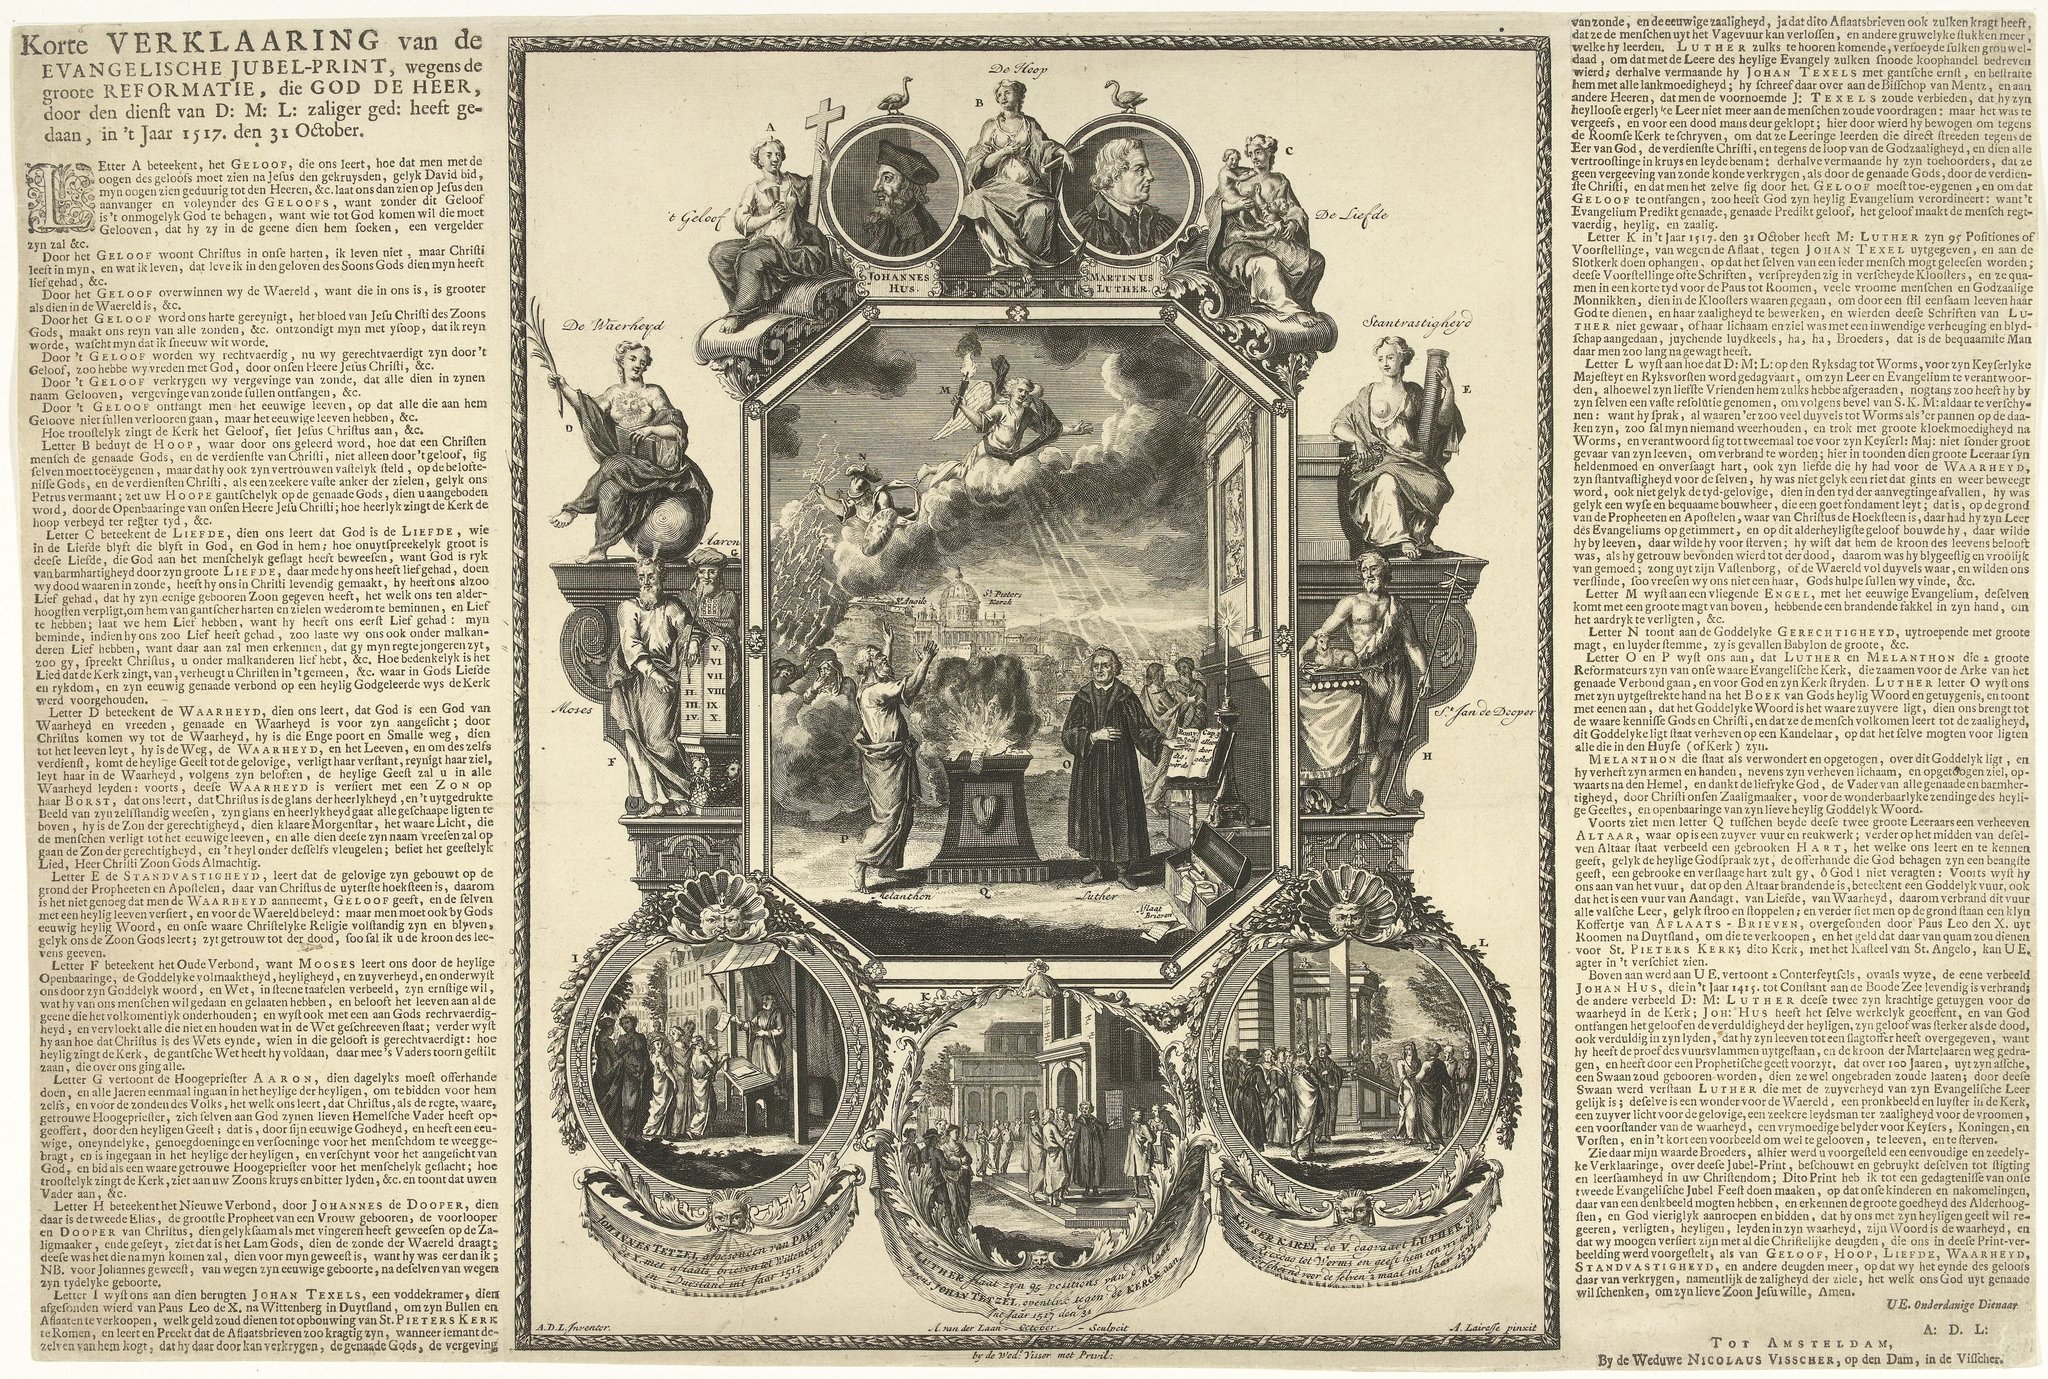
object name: print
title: Evangelische jubelprent bij het tweede eeuwfeest van de reformatie, 1717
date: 1717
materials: paper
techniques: engraving, etching, letterpress printing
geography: amsterdam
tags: priest, martin luther, the three theological virtues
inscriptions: collector's mark: Lugt 2228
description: Evangelische jubelprent bij de viering van het tweede eeuwfeest van de reformatie, 31 oktober 1717. Centrale voorstelling met Luther en Melanchton bij een altaar waarop het Goddelijke Vuur de Valse Leer verbrandt, in een omlijsting versierd met portretten van Hus en Luther, drie scènes uit het leven van Luther, bijbelse leiders en de personificaties van de Waarheid, Geloof, Hoop, Liefde en Standvastigheid. Gedrukt op het blad aan weerszijden van de plaat de verklaring van de voorstelling.